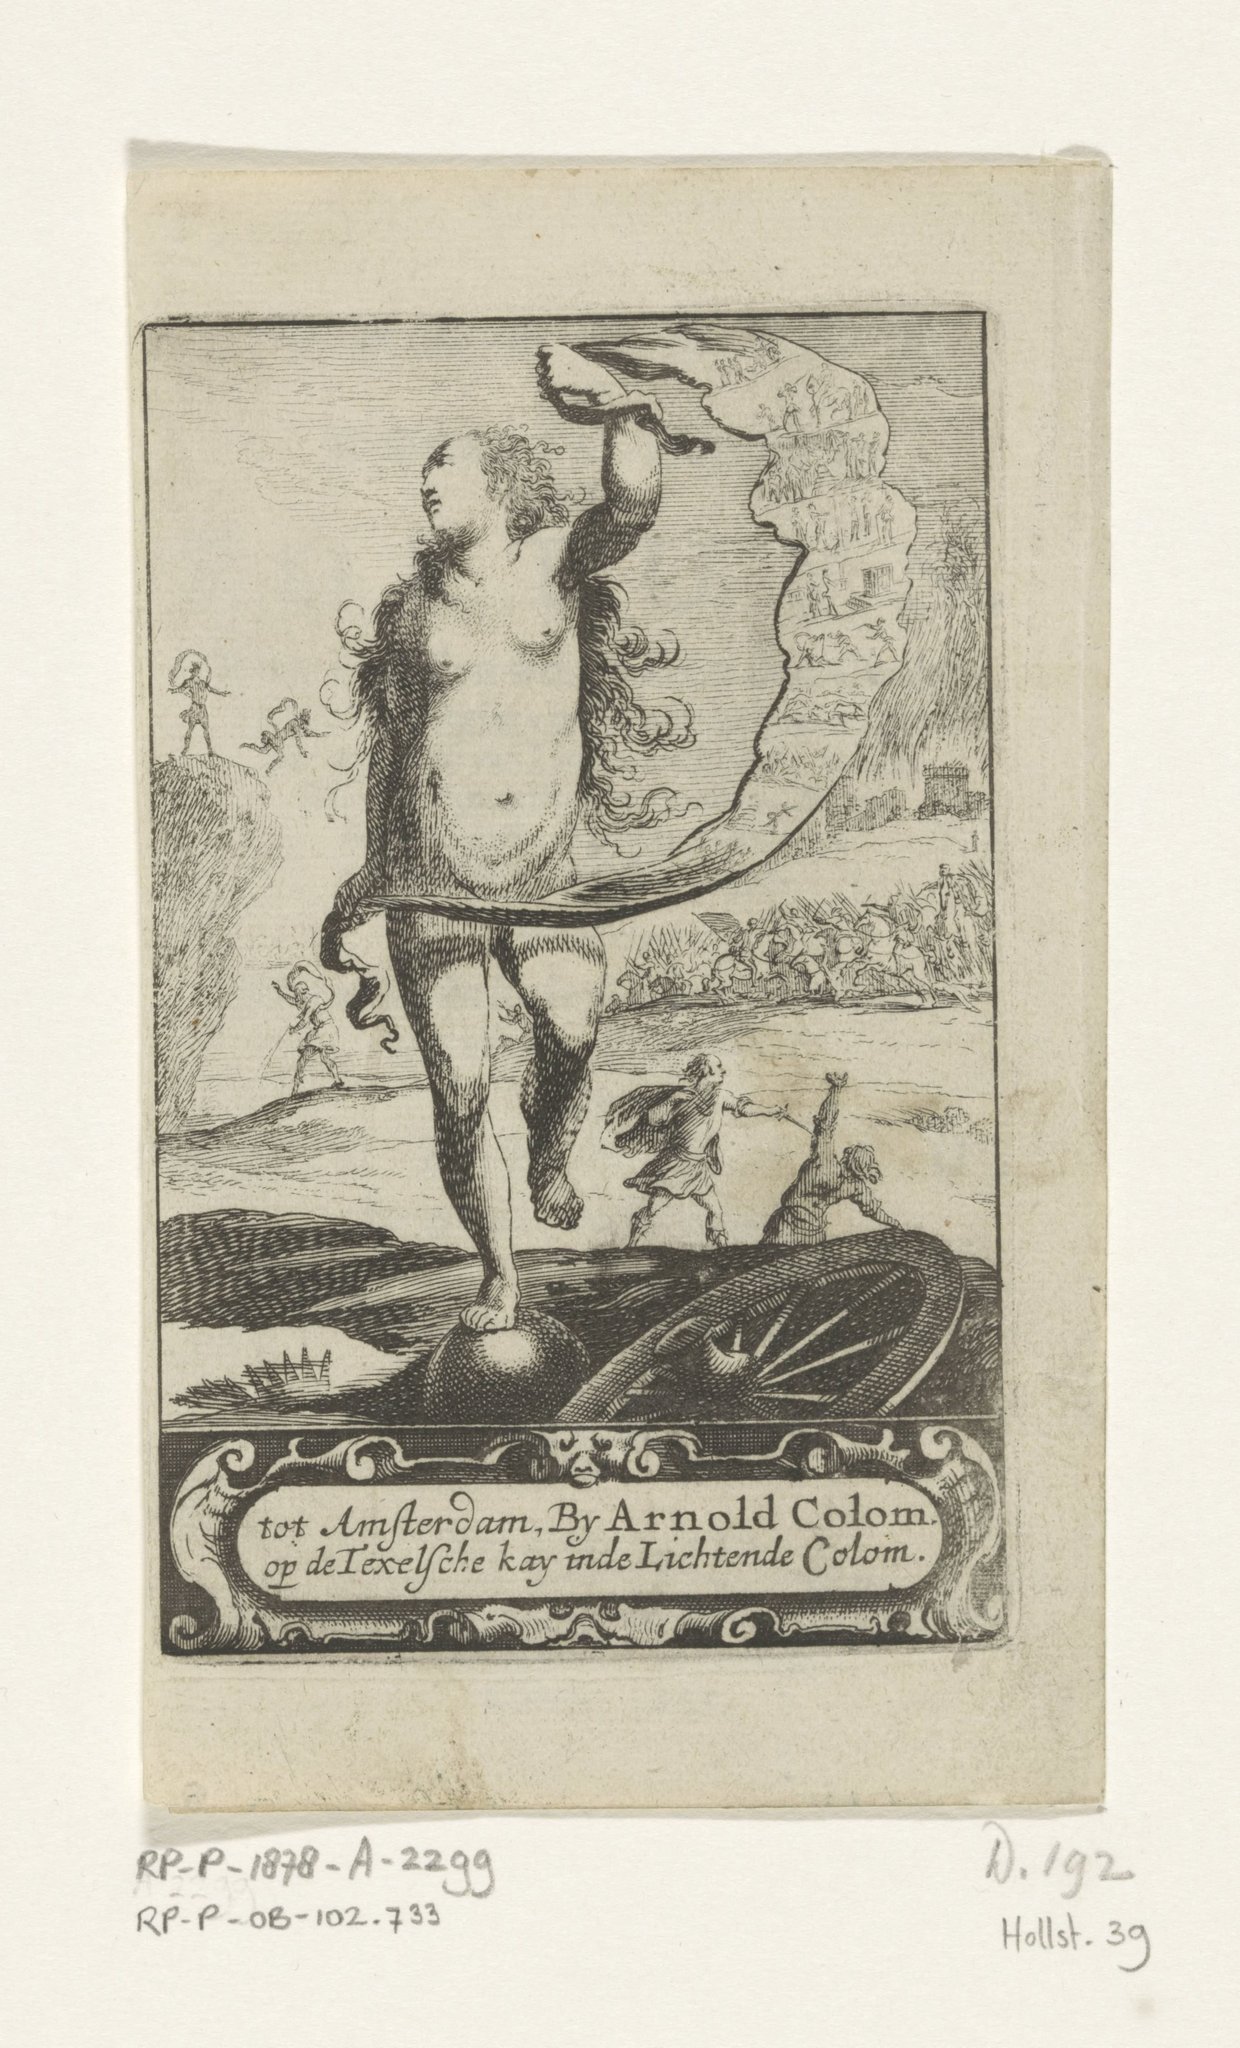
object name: print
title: Titelpagina voor: Urbain Chevreau, Ydelheydt en ongestadigheyt der fortuyn, 1651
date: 1651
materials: paper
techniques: engraving, etching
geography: amsterdam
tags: fortune and misfortune (+ personification), on fire, ablaze, luck, fortune, lot; 'fato', 'fortuna', 'fortuna aurea', 'fortuna buona', 'fortuna pacifica overo clemente', 'sorte' (ripa), killing ~ aggressive relationships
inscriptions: collector's mark: Lugt 2228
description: De naakte Fortuna staat met een banderol in haar handen op de globe. Naast haar ligt het rad van fortuin. Achter haar steekt een man een andere man, terwijl een man van een hoge rots valt. Rechtsachter een brandende stad en een ruitergevecht. Deze voorstellingen verbeelden de wispelturigheid van Fortuna.